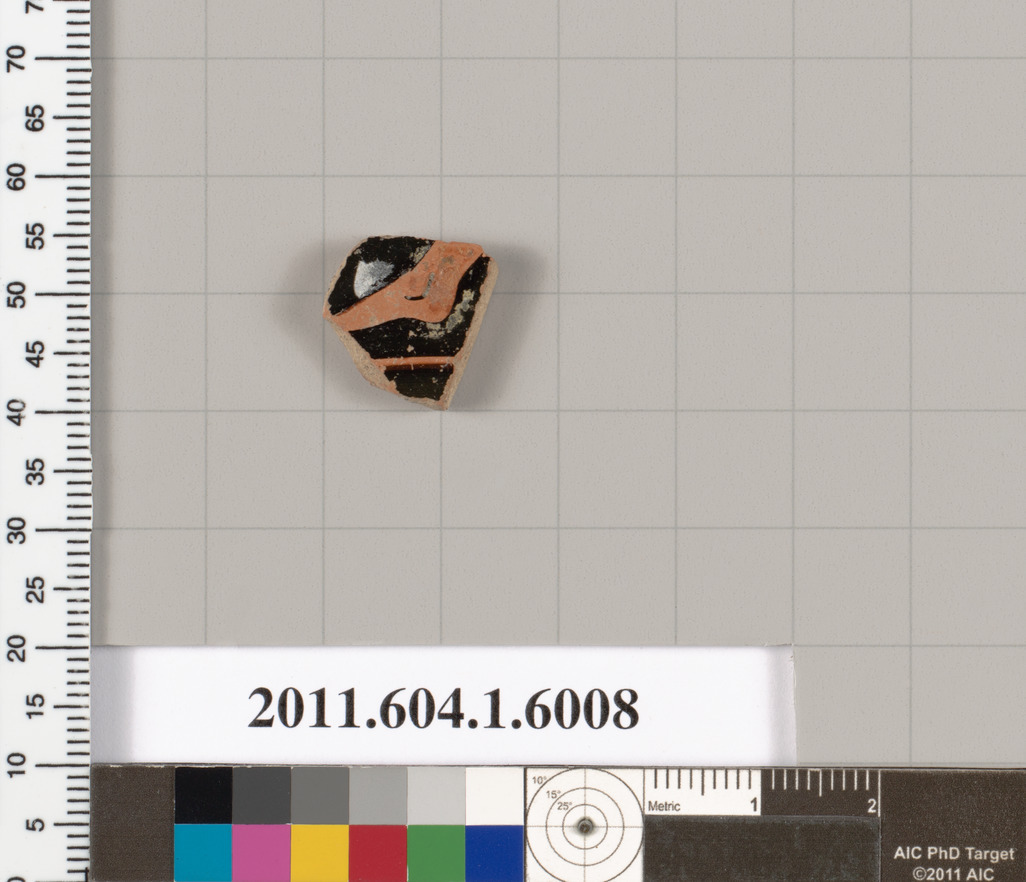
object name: kylix fragment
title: Terracotta fragment of a kylix (drinking cup)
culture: greek, attic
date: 510-500 BCE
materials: terracotta